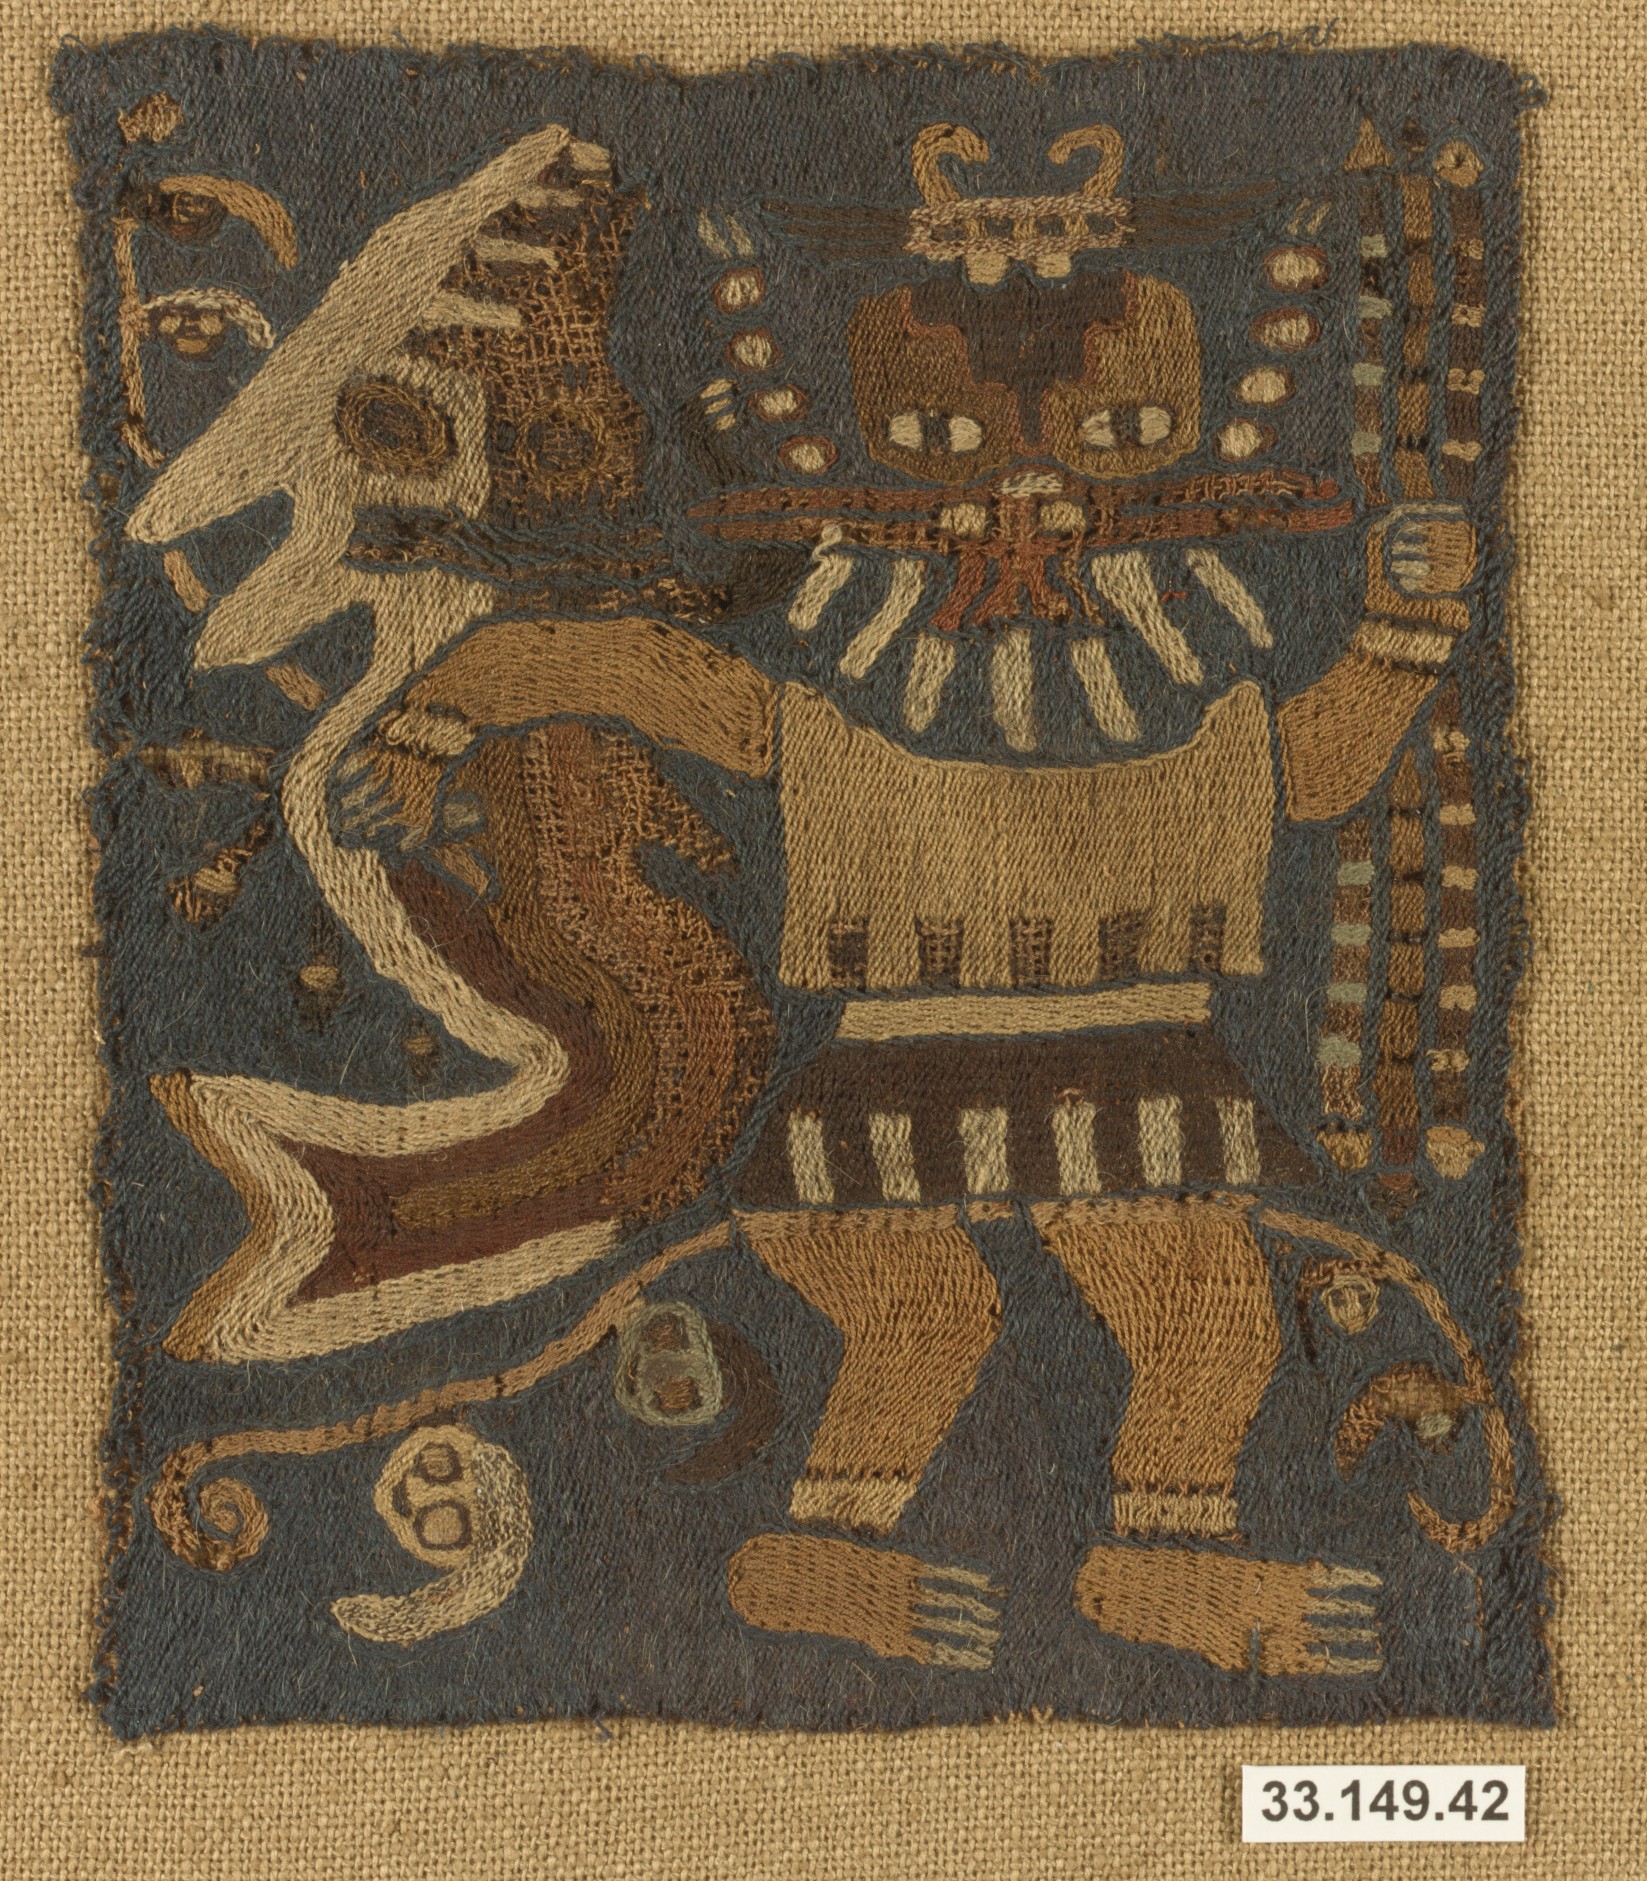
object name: mantle fragment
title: Embroidered Mantle Fragment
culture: paracas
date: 300-101 BCE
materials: animal fiber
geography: peru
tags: human figures,heads,fish